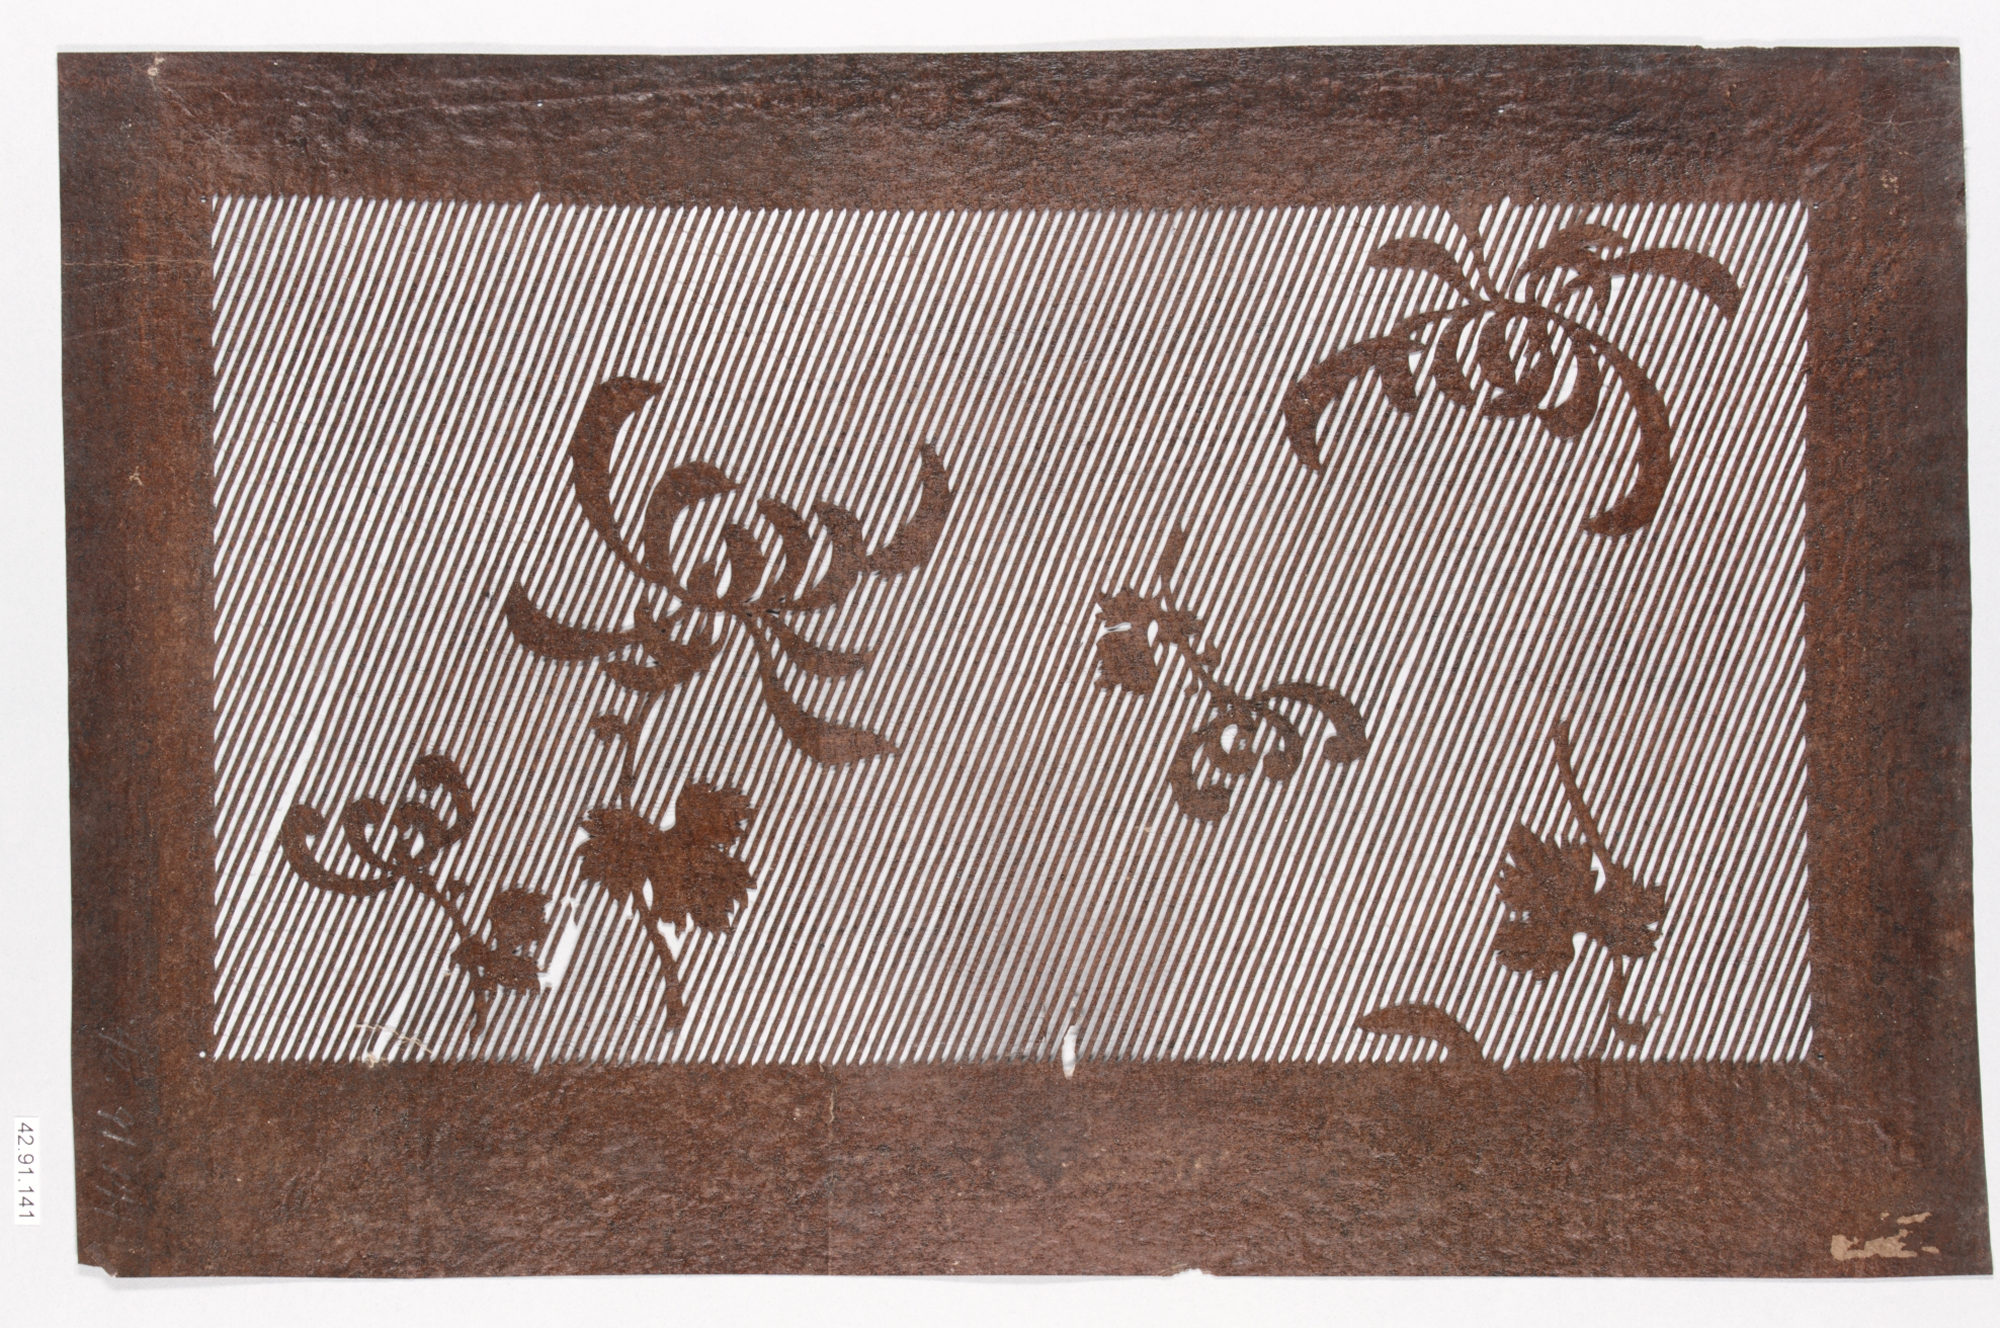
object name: stencil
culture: japanese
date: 1801-1900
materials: paper, silk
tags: flowers